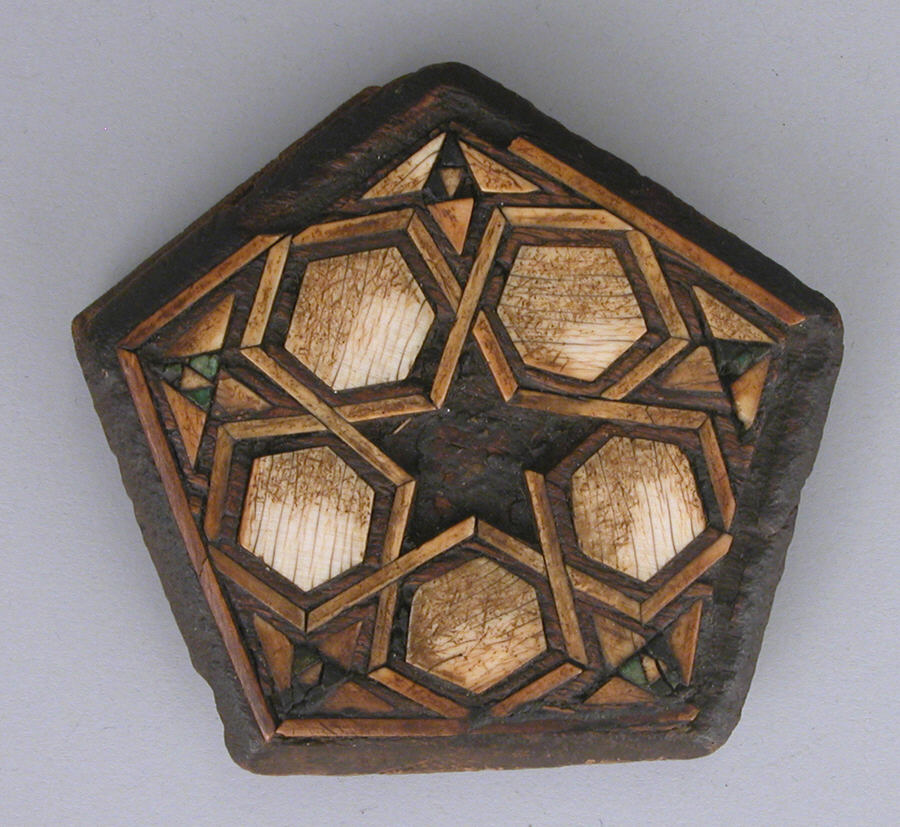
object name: panel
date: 1301-1500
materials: ivory, wood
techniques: inlay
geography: egypt